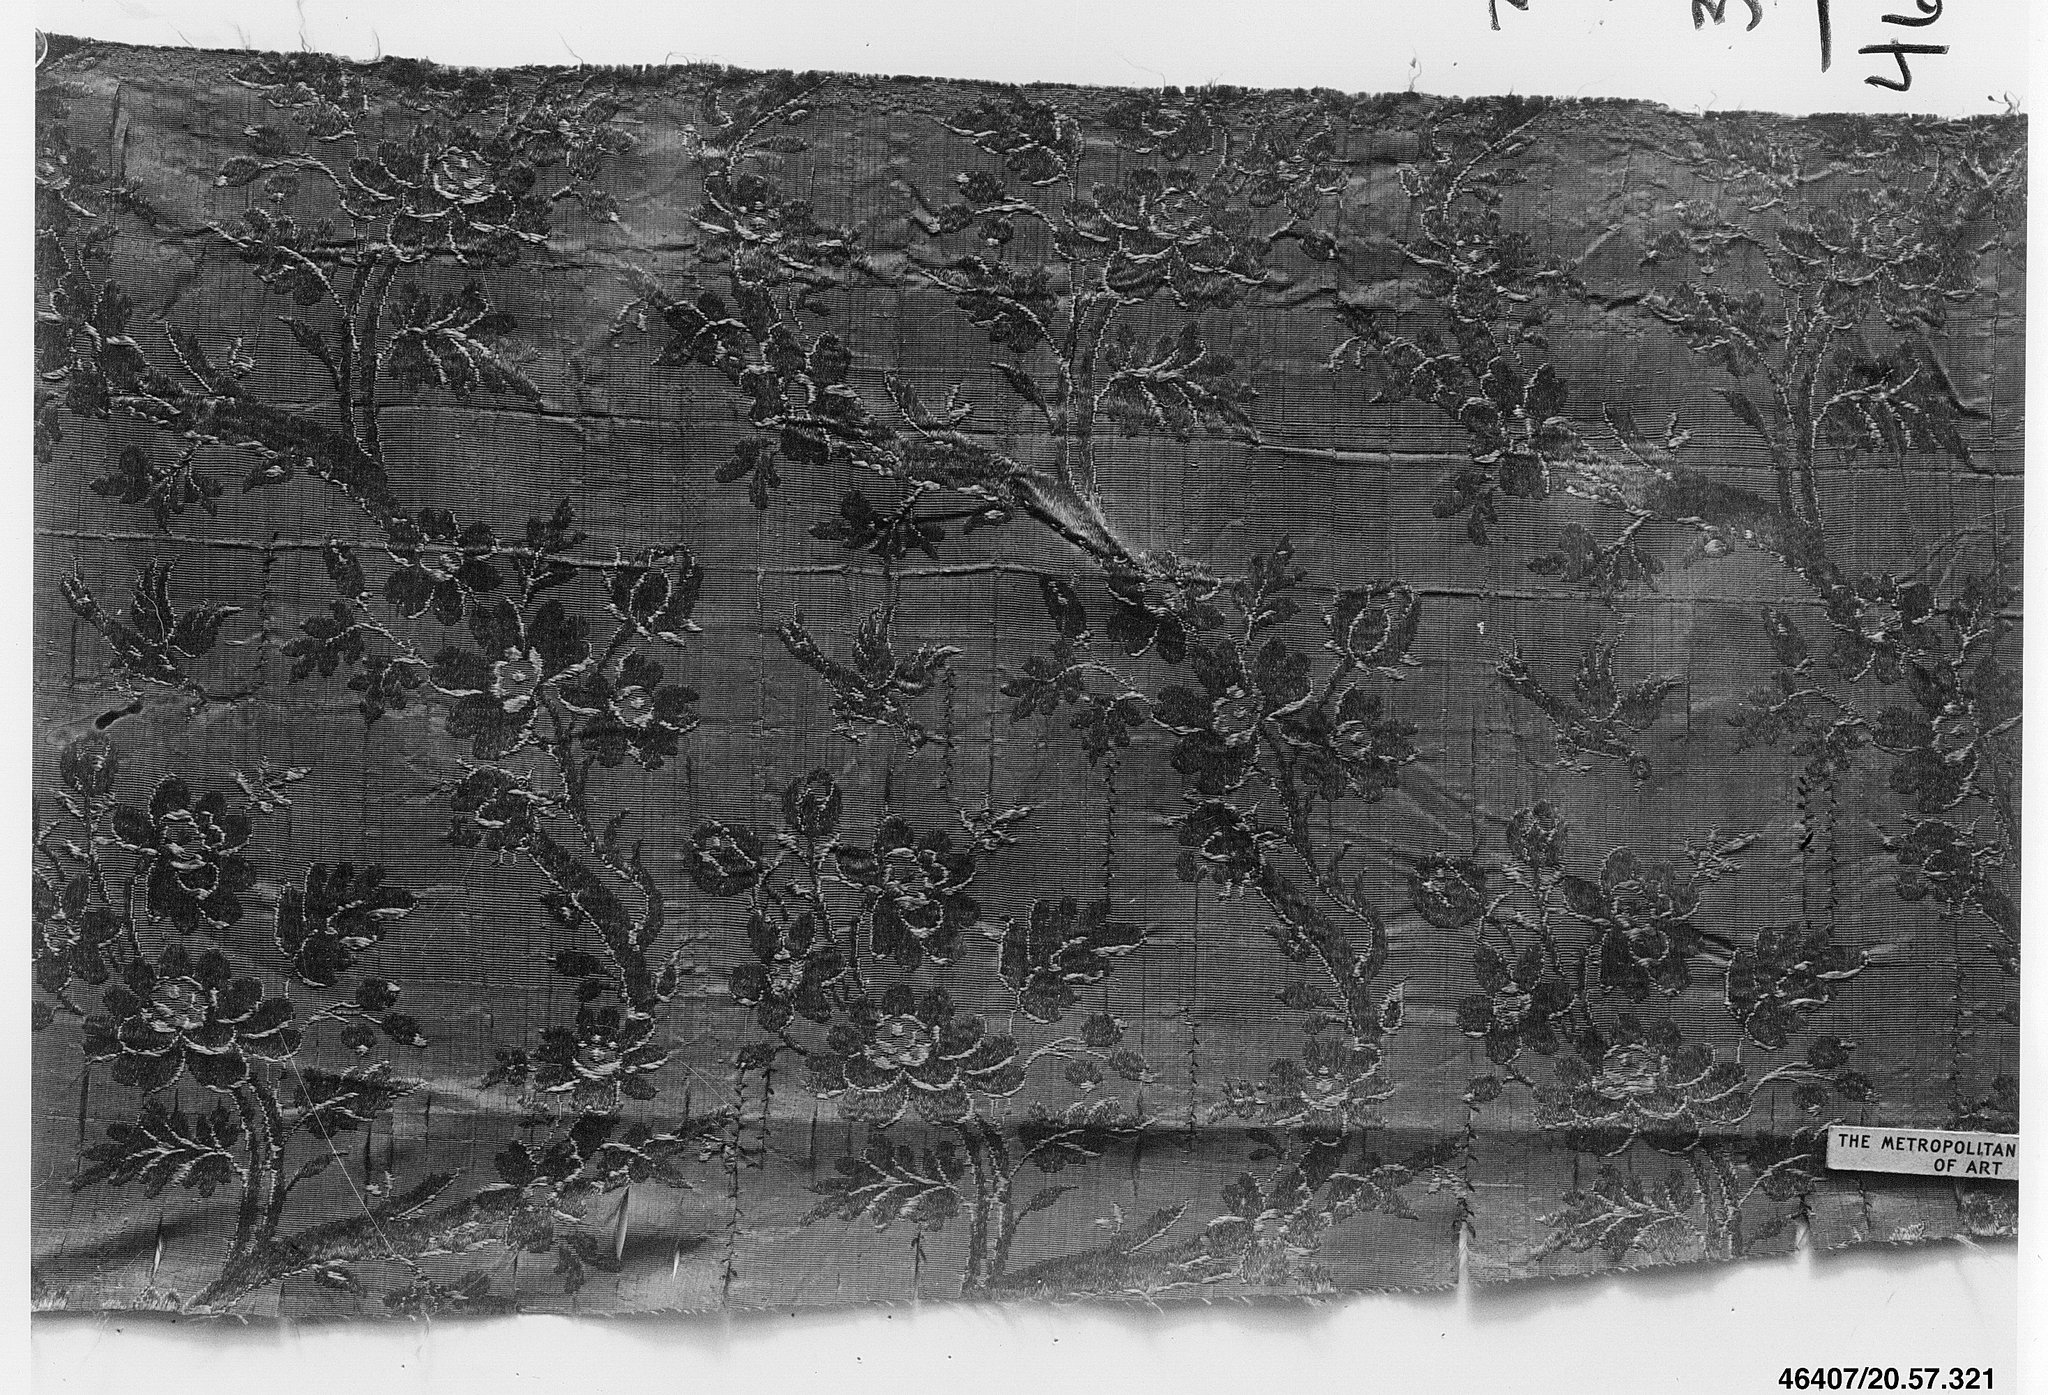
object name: piece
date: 1760-1770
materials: silk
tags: flowers,leaves